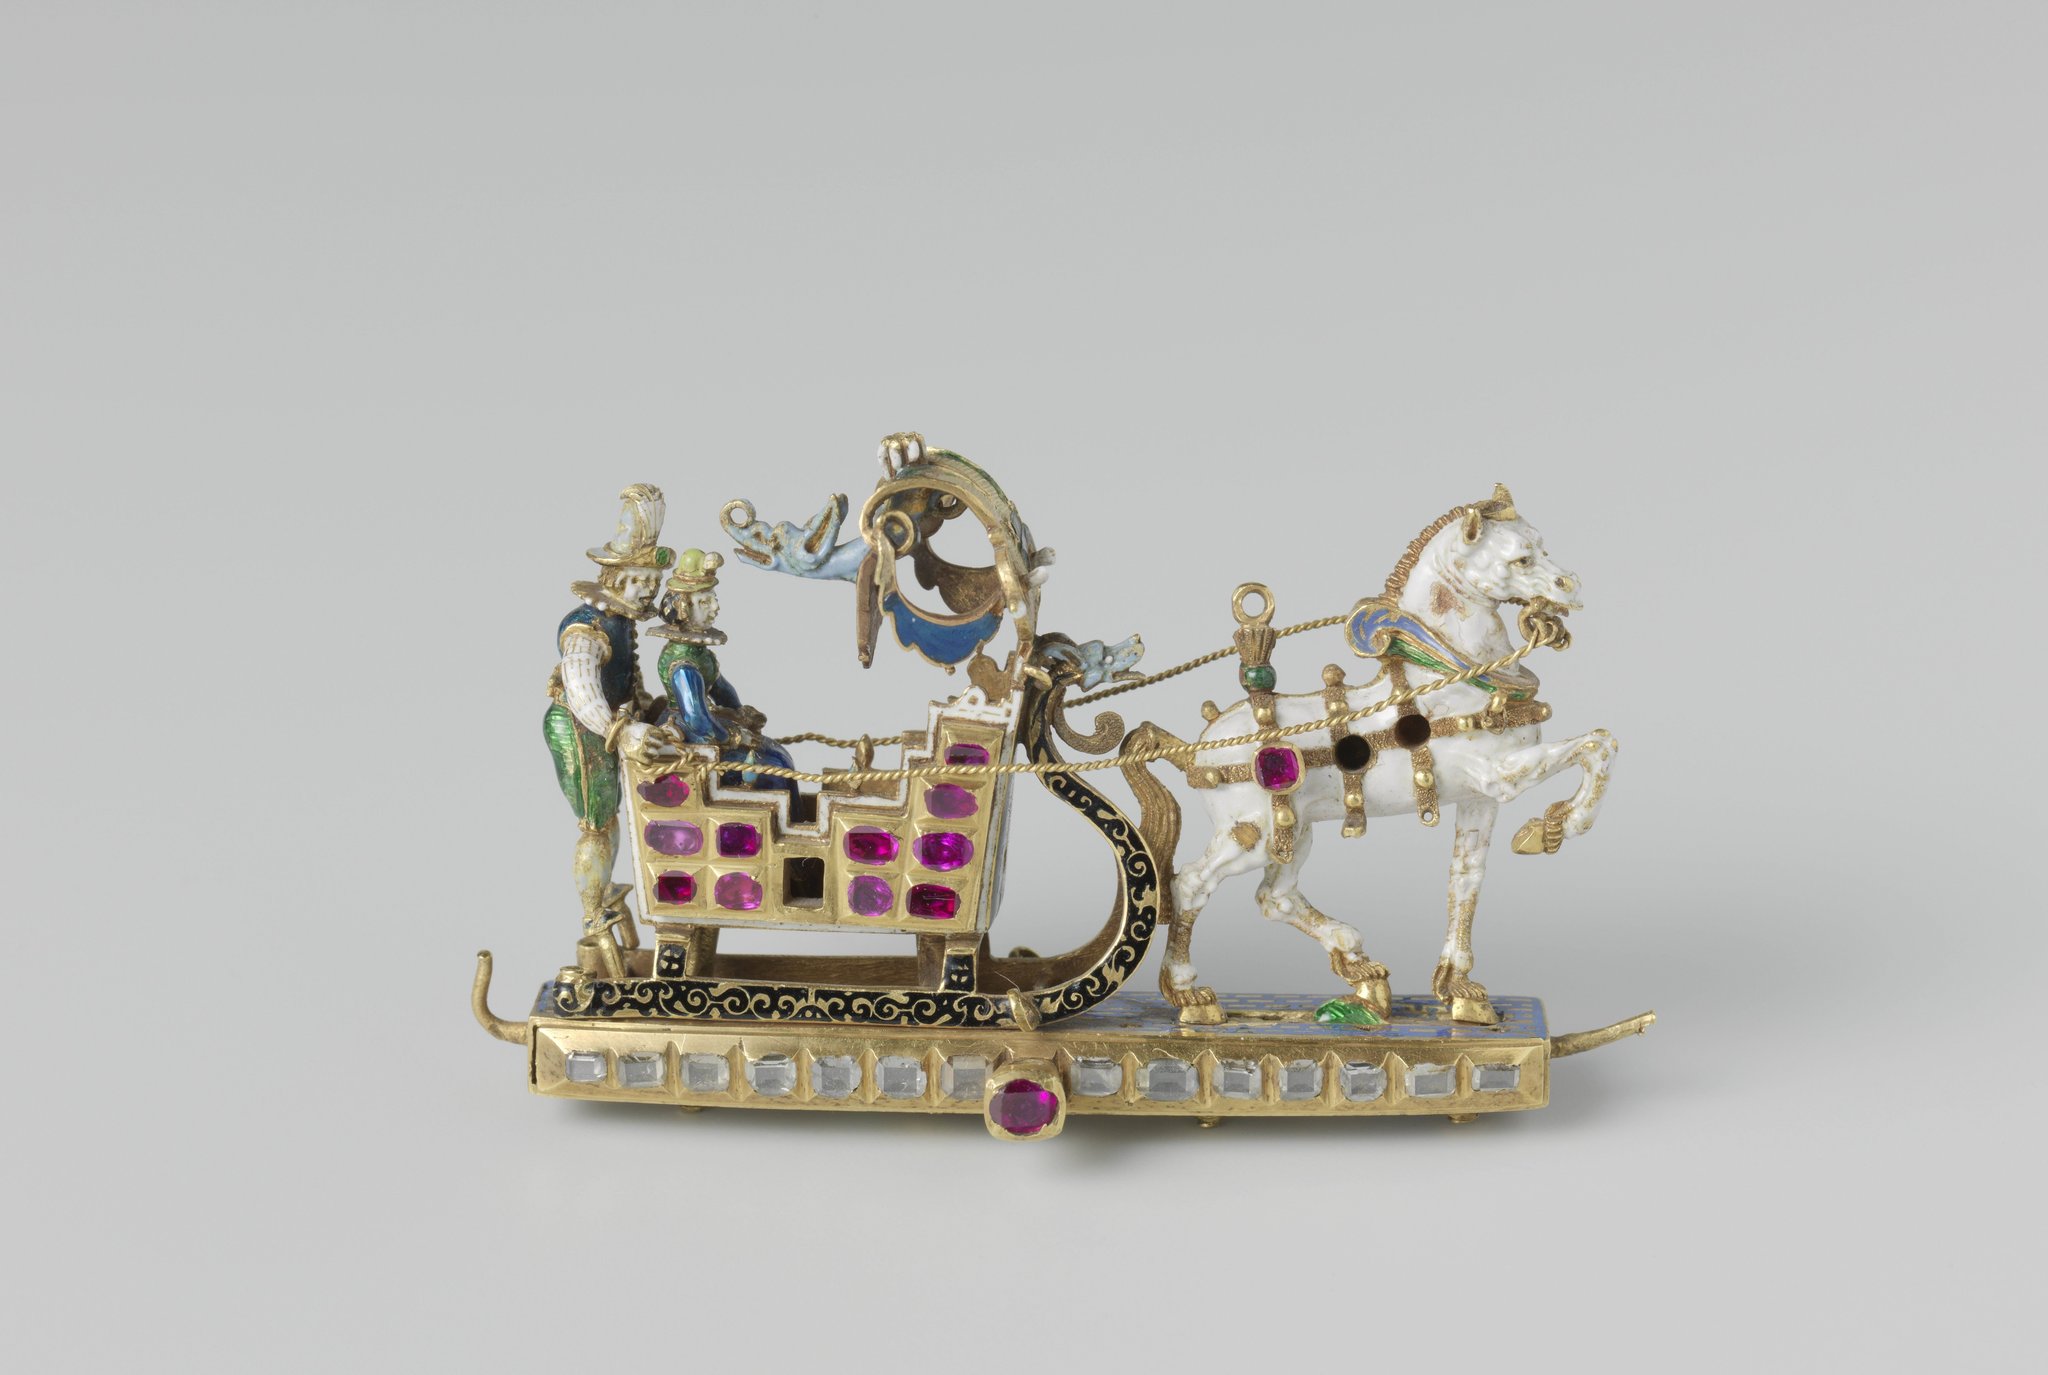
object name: pendant jewelry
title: Hanger met man en vrouw in een arrenslee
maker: Anonymous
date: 1600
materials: diamond, gold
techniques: enameling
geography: southern germany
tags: horse-sleigh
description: Pendant, sleigh-ride. Gold, gems and enamel. Southern Germany, c. 1600.